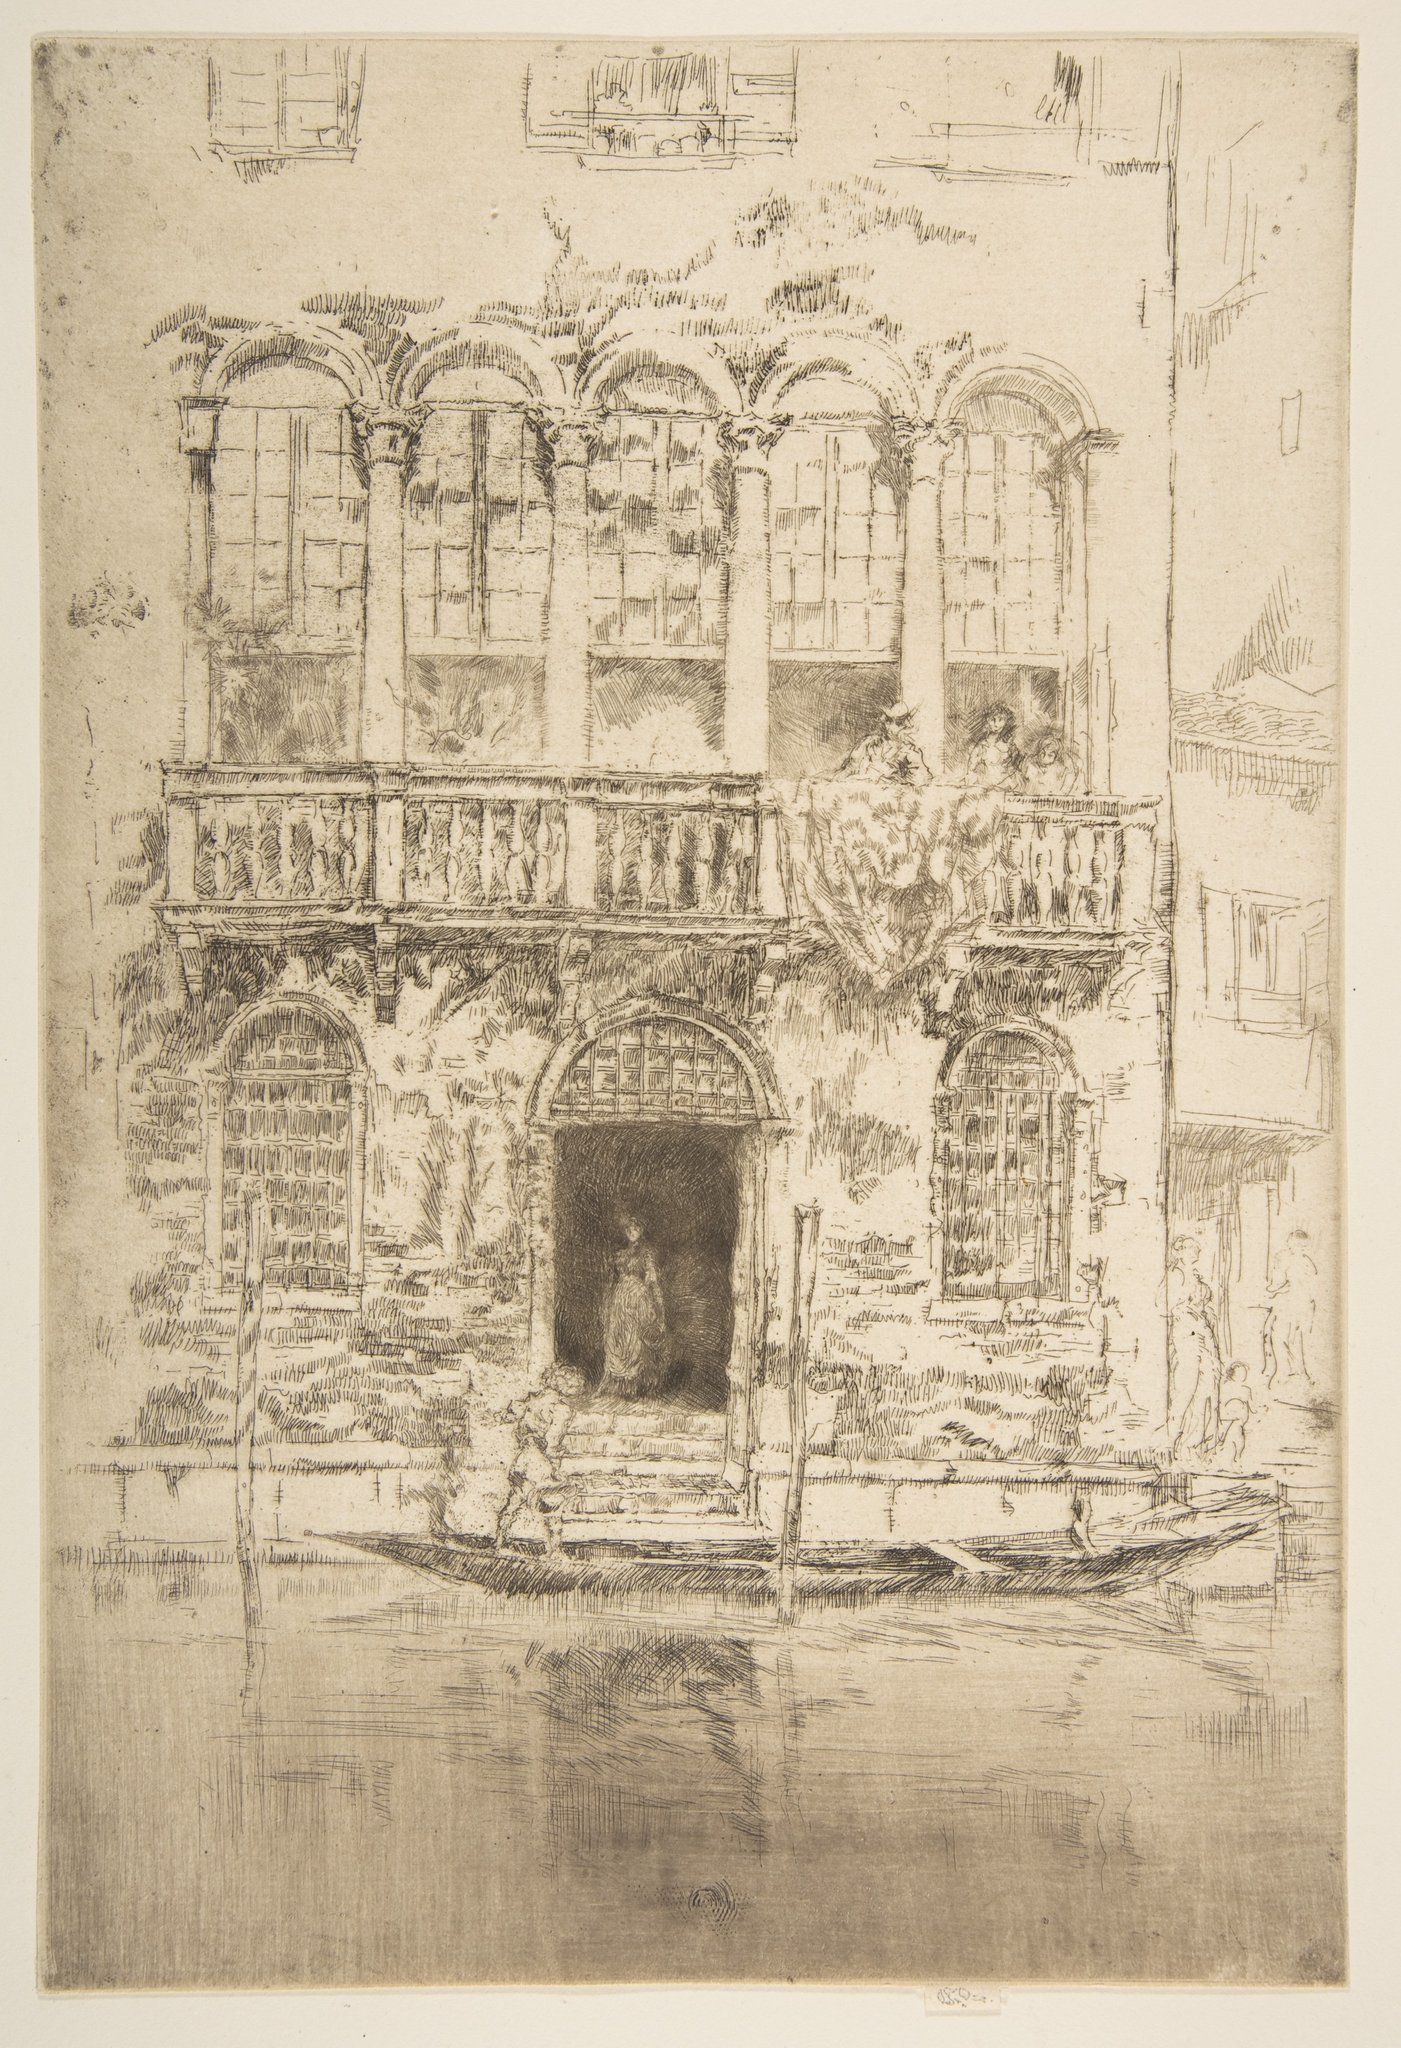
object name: print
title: The Balcony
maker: james mcneill whistler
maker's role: artist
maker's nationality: american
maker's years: 1834-1903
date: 1879-1880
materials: ink, ivory, paper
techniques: drypoint, etching, printing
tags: balconies,canals,boats,venice